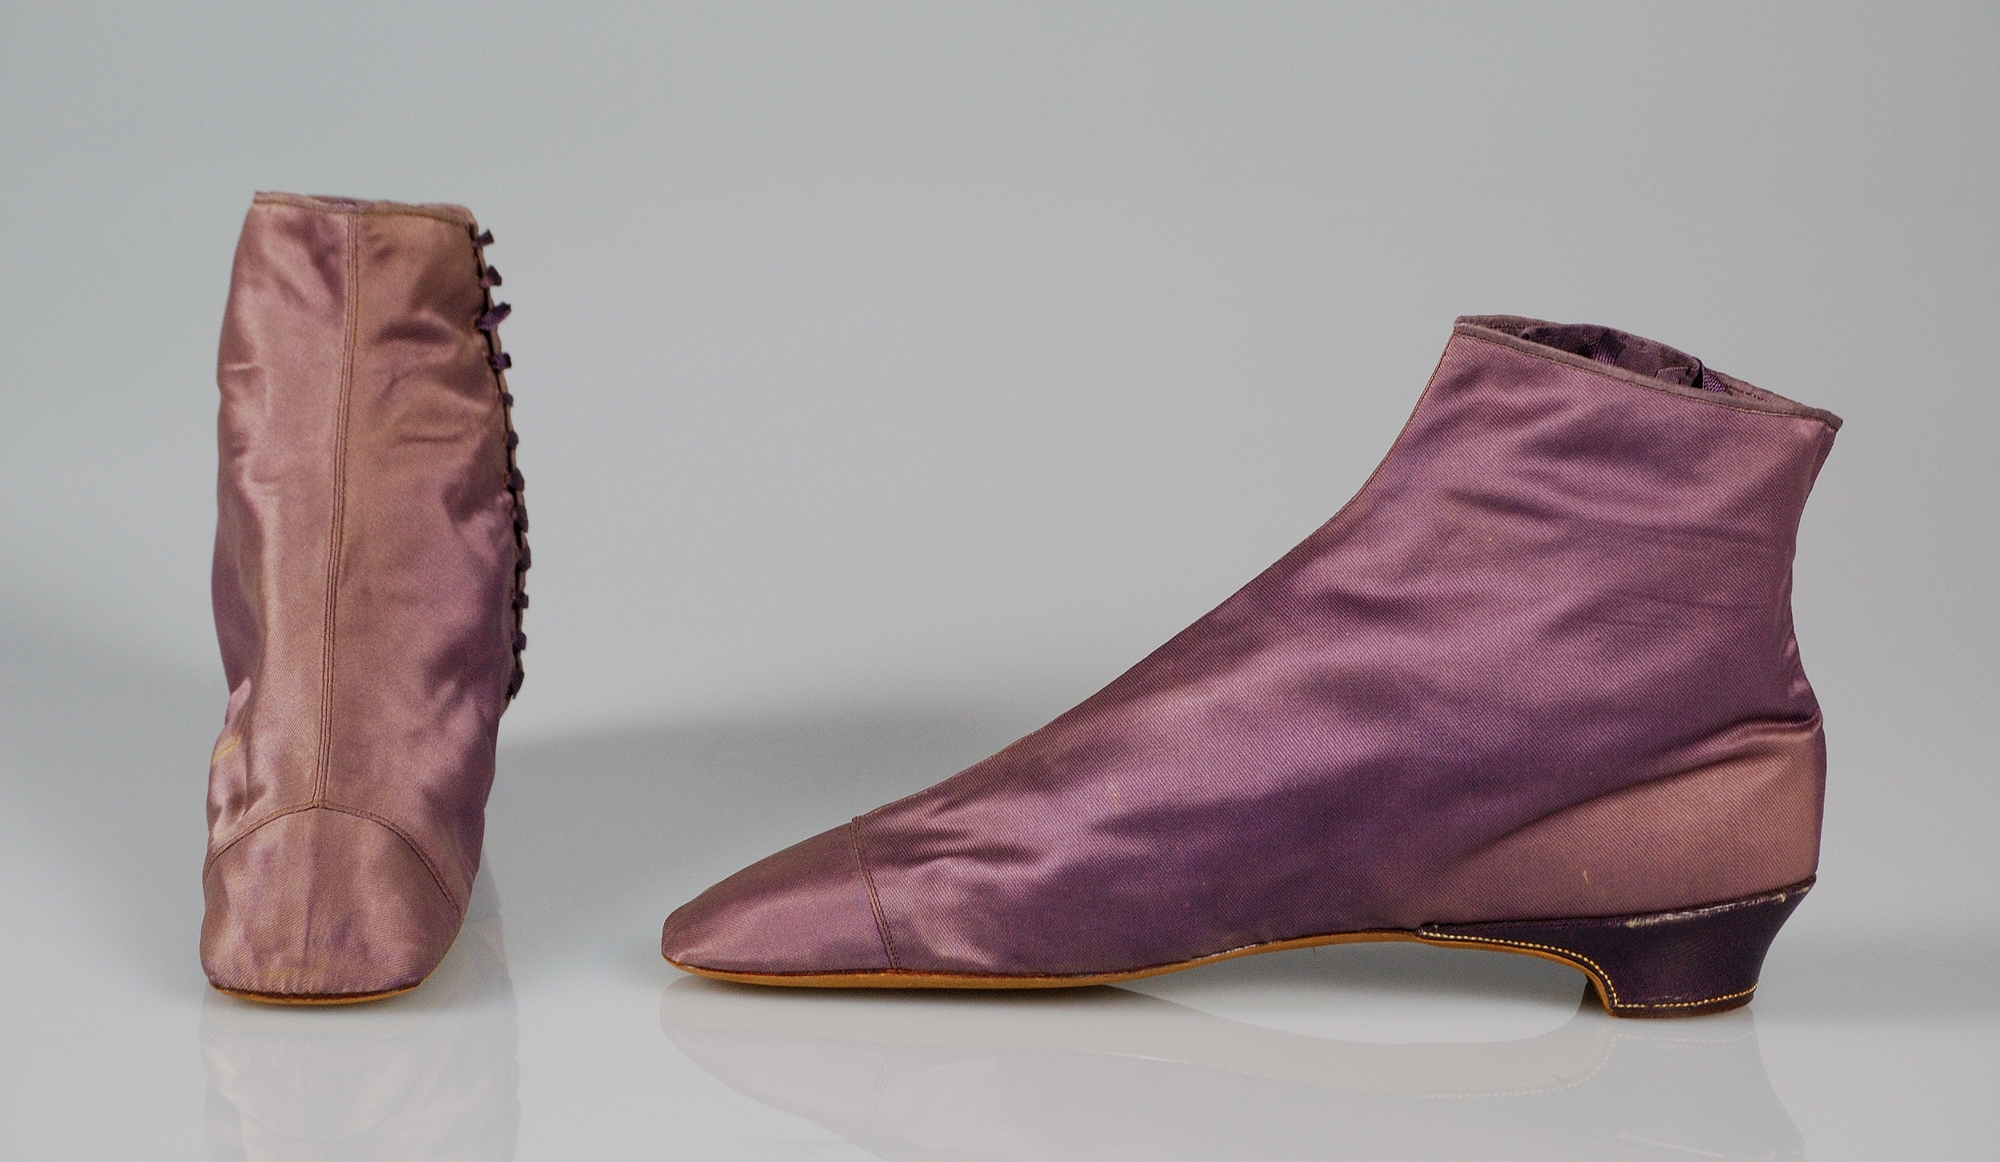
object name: boot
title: Boots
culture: french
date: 1855-1865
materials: silk